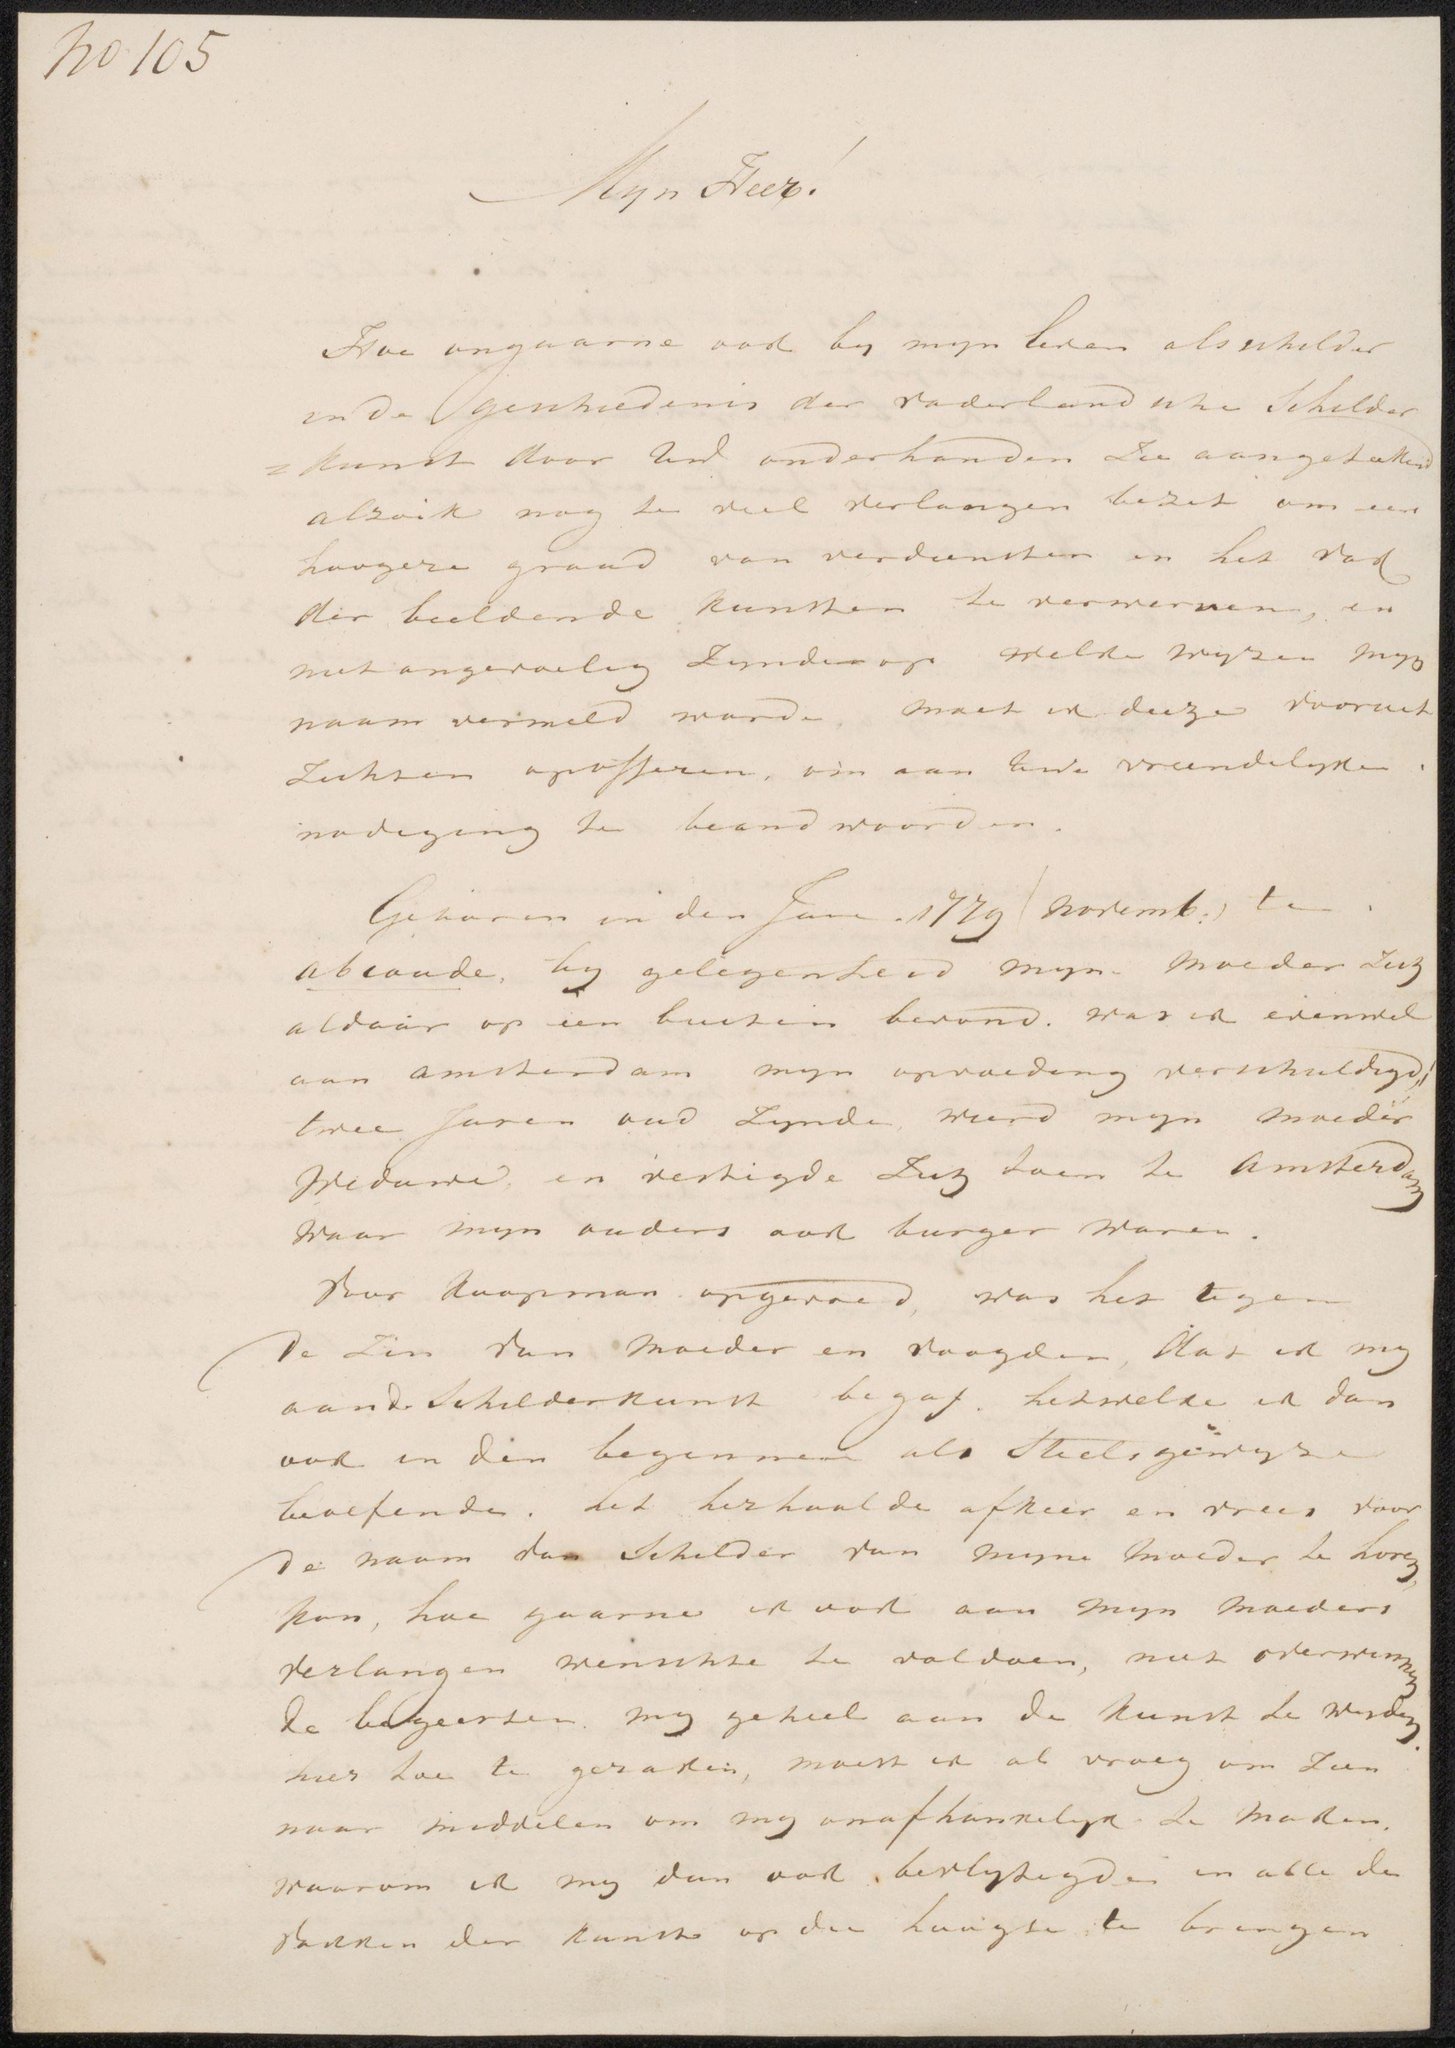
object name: letter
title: Brief aan anoniem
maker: jan willem pieneman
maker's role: draughtsman, painter, print maker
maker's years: 1779-1853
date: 1789-1853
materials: ink, paper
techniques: pen, writing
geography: the hague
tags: education, tuition of the artist (in general), painting (including book-illumination, miniature-painting)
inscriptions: watermark